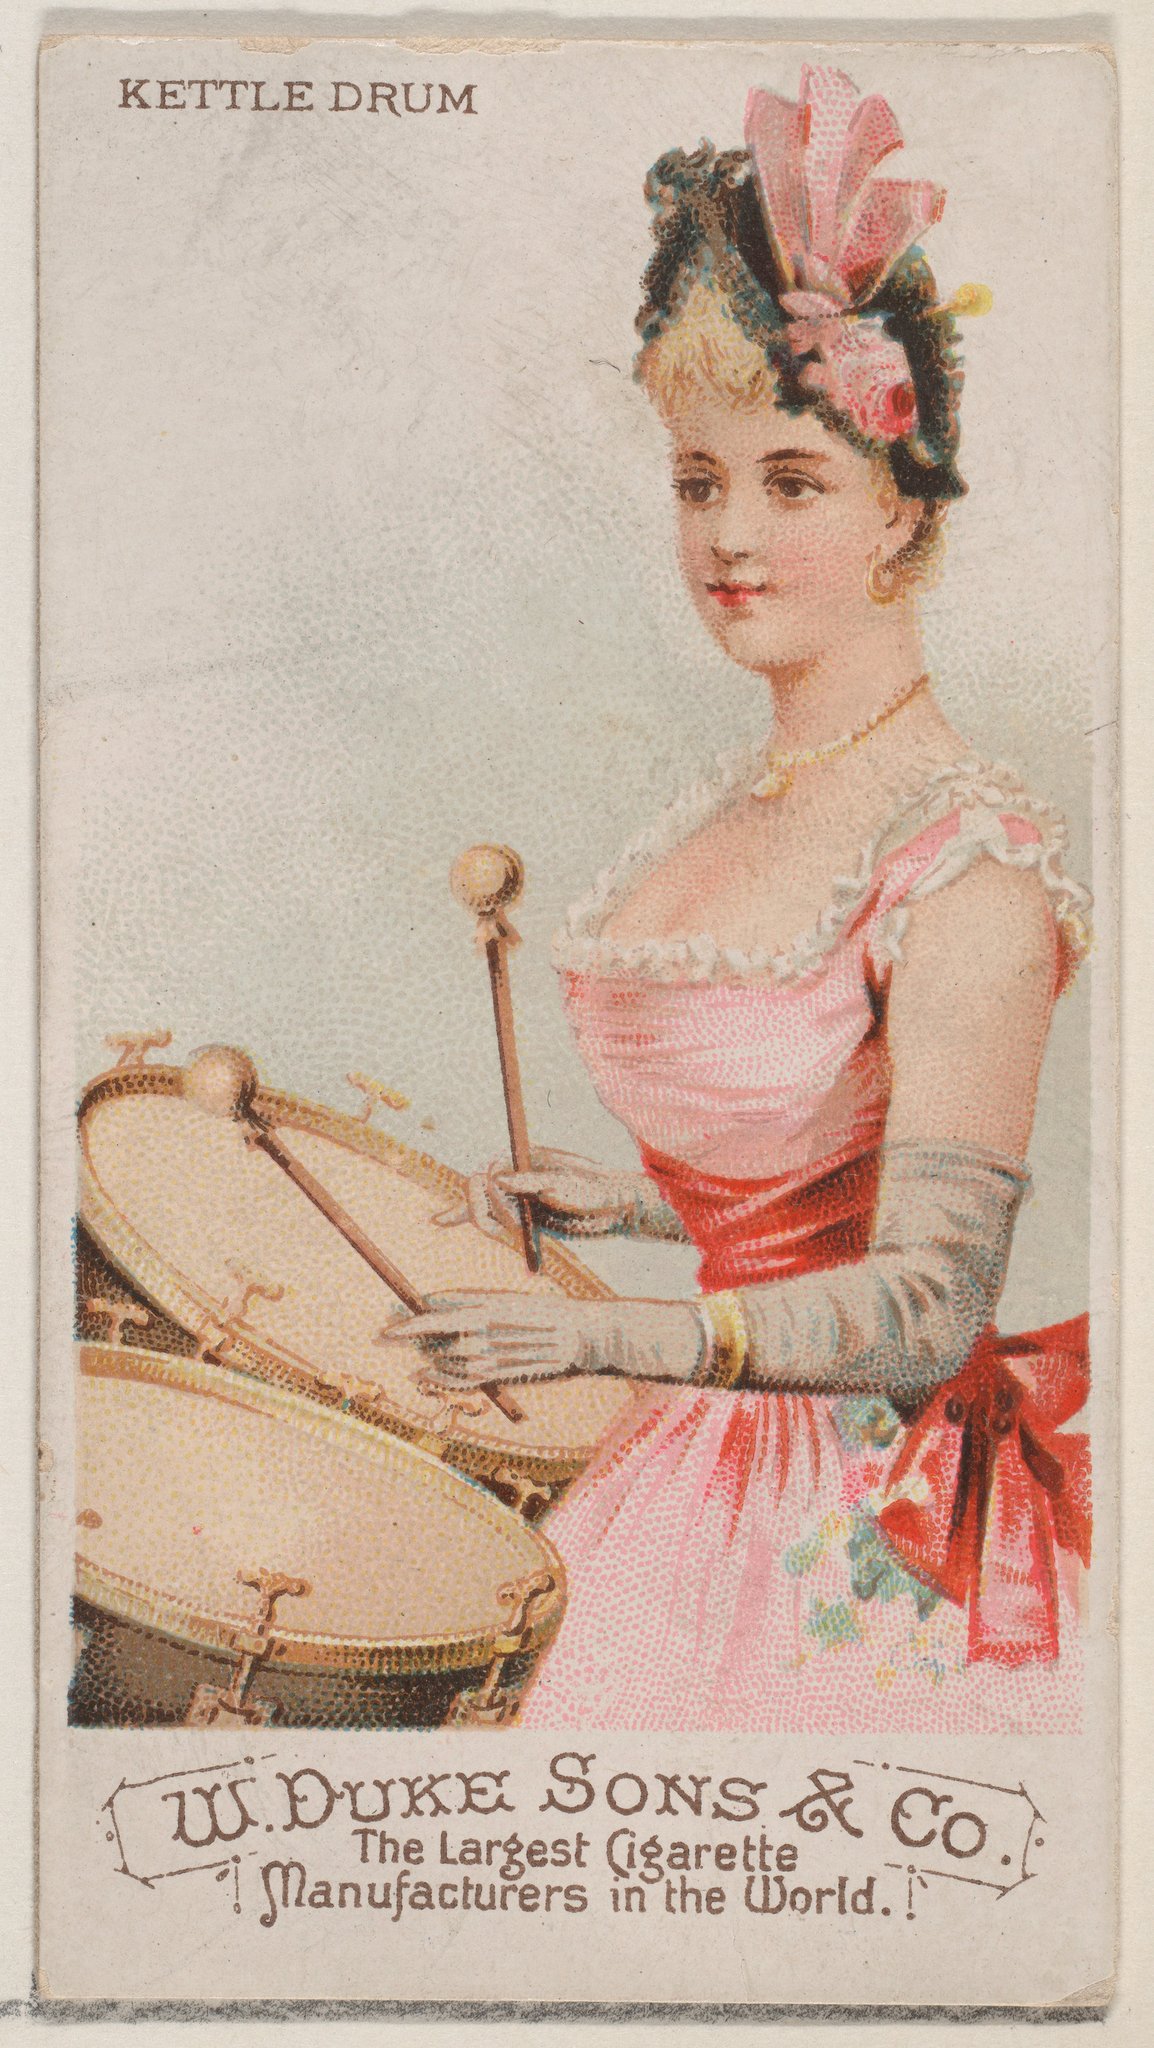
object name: print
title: Kettle Drum, from the Musical Instruments series (N82) for Duke brand cigarettes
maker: w. duke, sons & co.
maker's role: publisher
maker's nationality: american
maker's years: 1870-1920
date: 1888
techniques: color lithograph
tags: women,drums,musicians